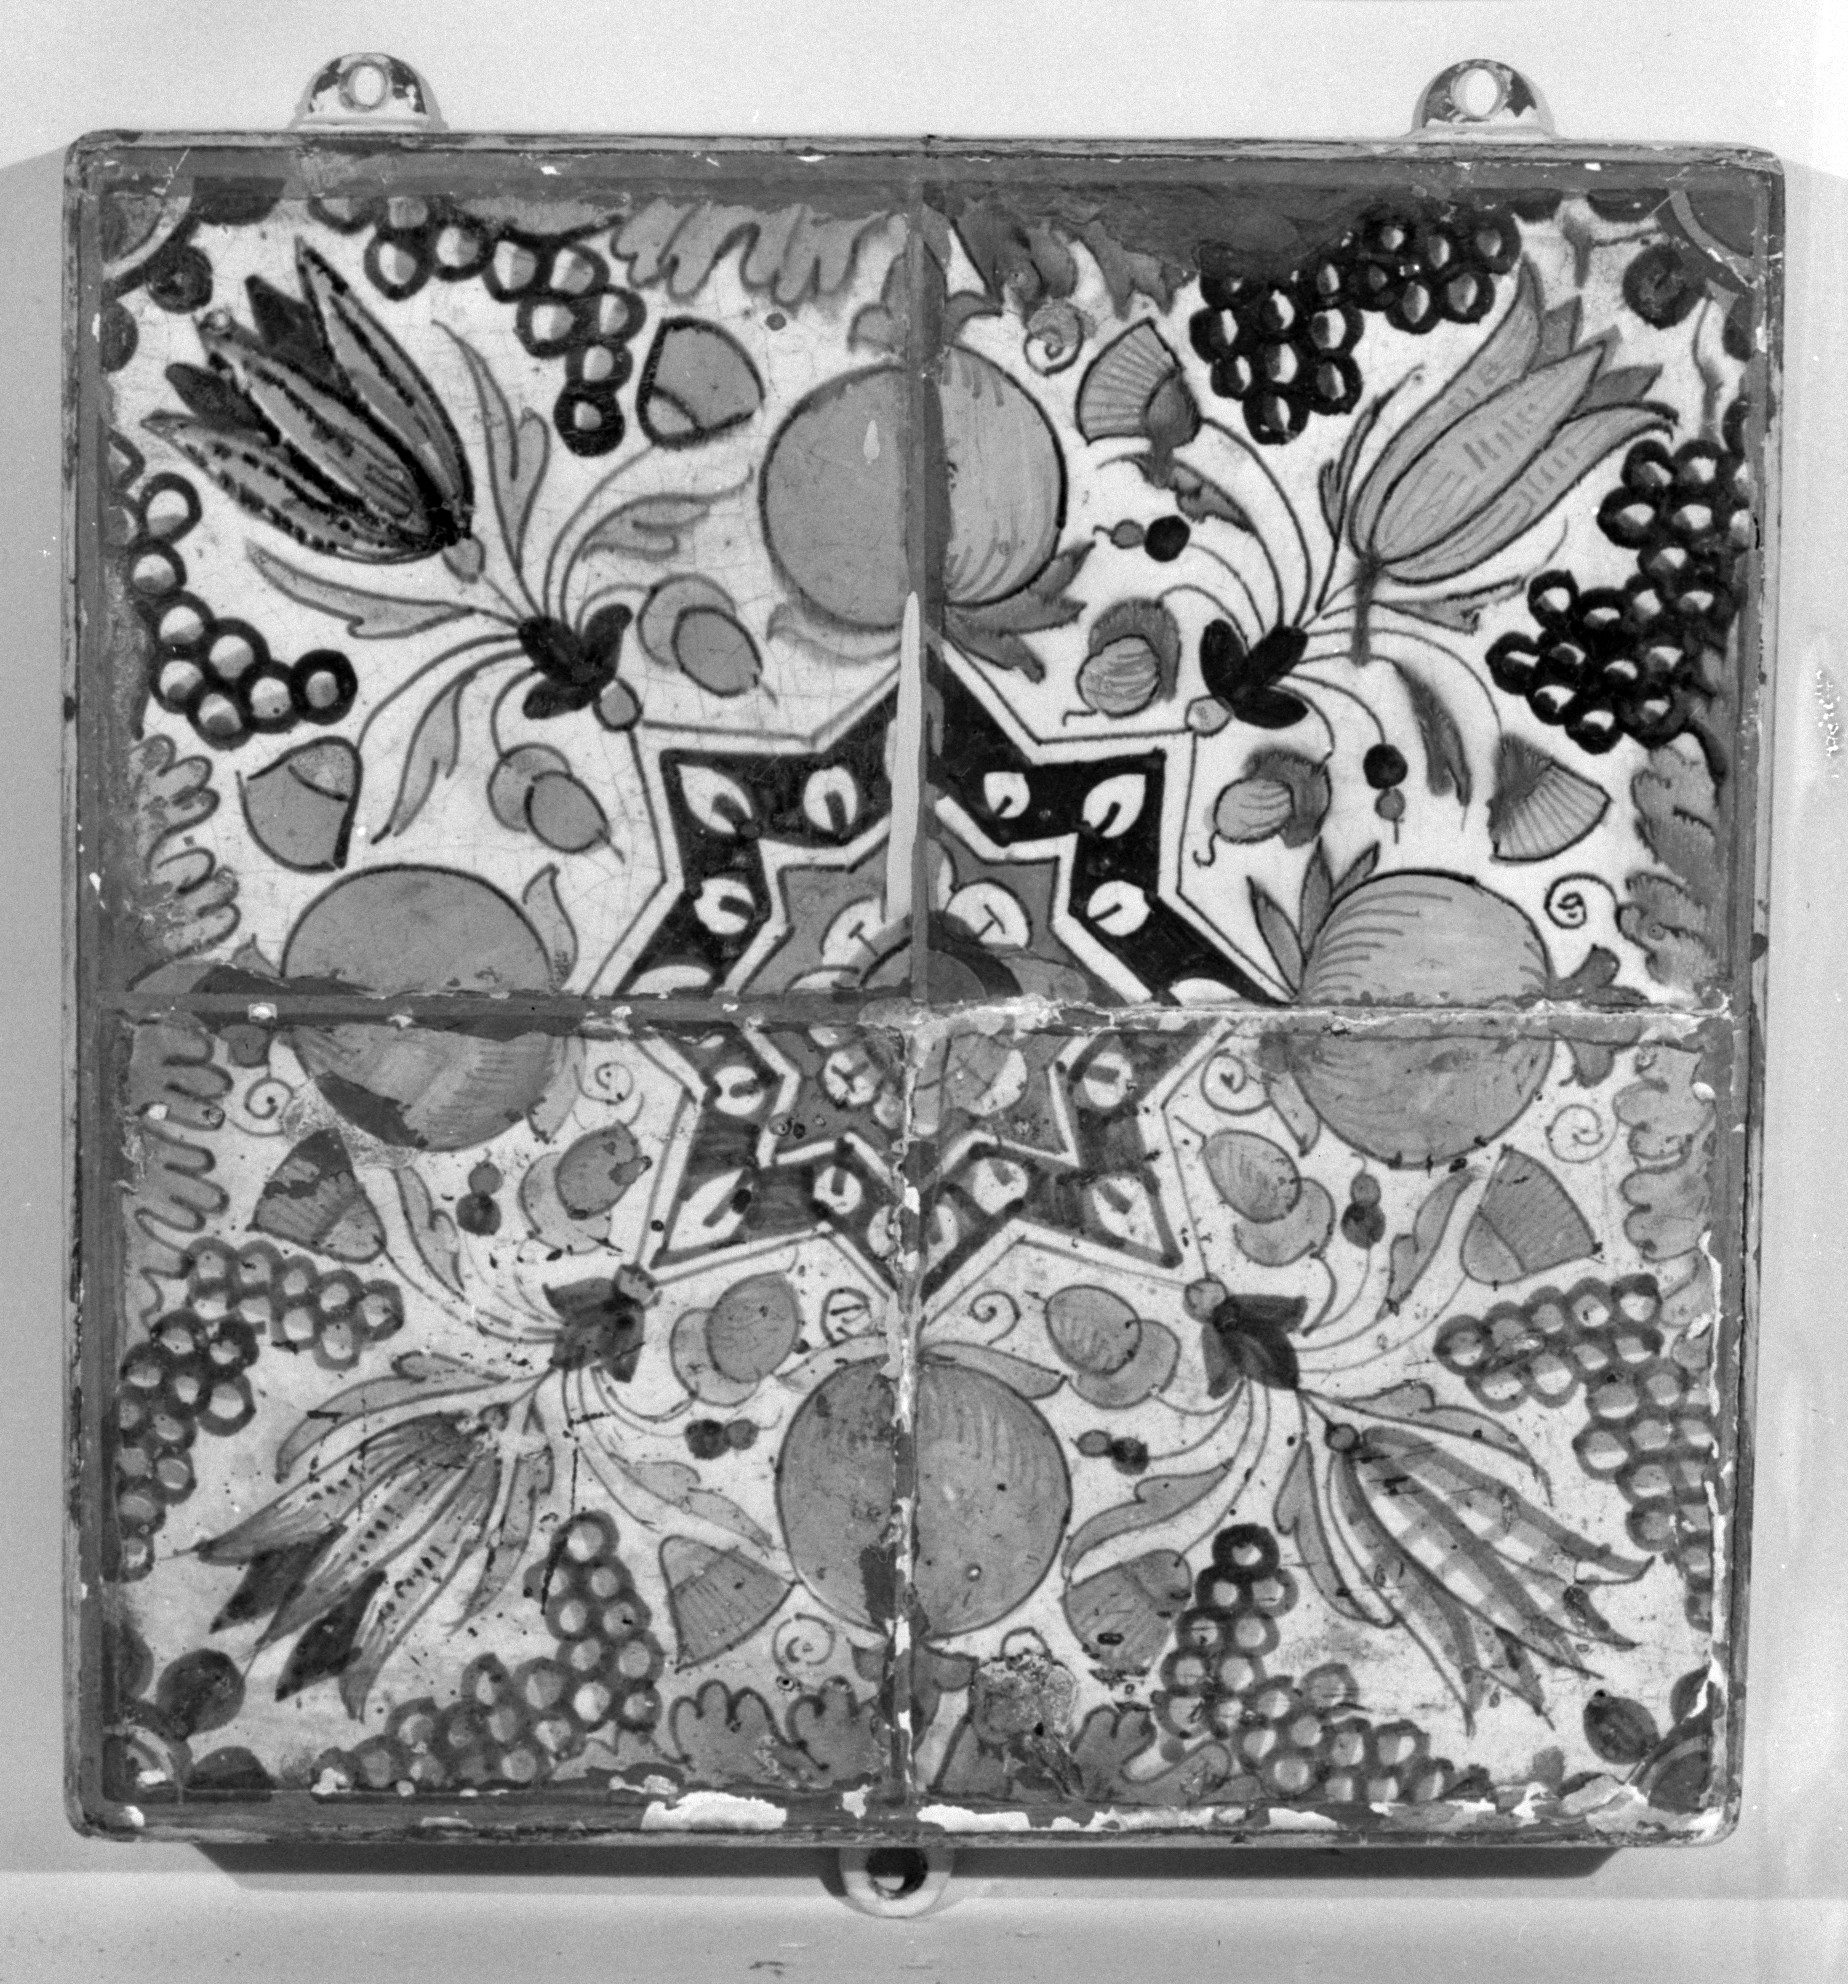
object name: tile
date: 1601-1625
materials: earthenware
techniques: glazing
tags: fruit,flowers